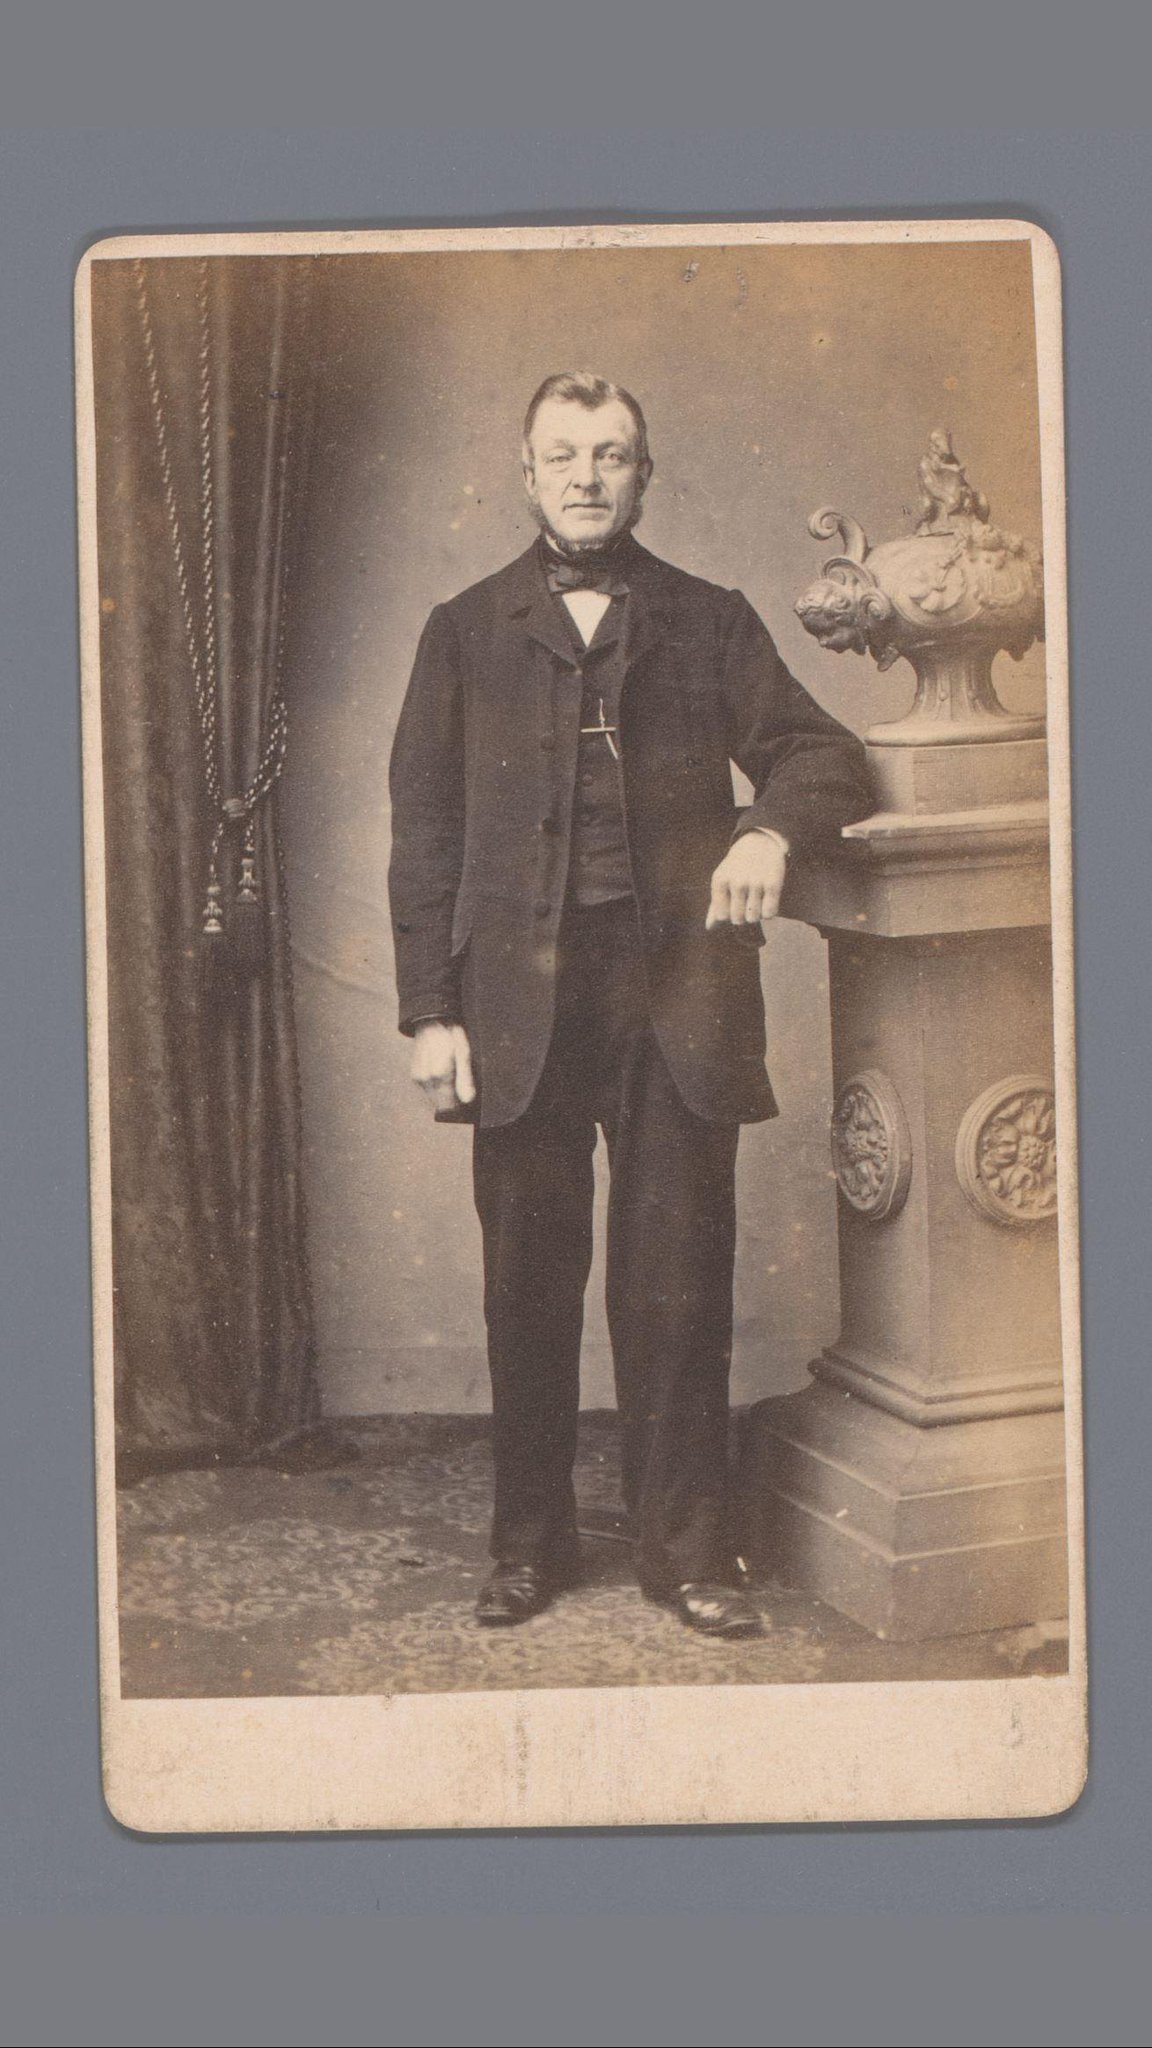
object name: photograph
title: Portret van een onbekende man, staande naast een sokkel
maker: a.k. de koningh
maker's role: fotograaf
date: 1864-1867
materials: cardboard, paper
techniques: albumen print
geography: amersfoort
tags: adult man, historical persons, pedestal of a piece of sculpture (perhaps in the form of a herm)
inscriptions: inscription: ‘Photographie/ van/ A.K. de Koningh,/ Amersfoort.’